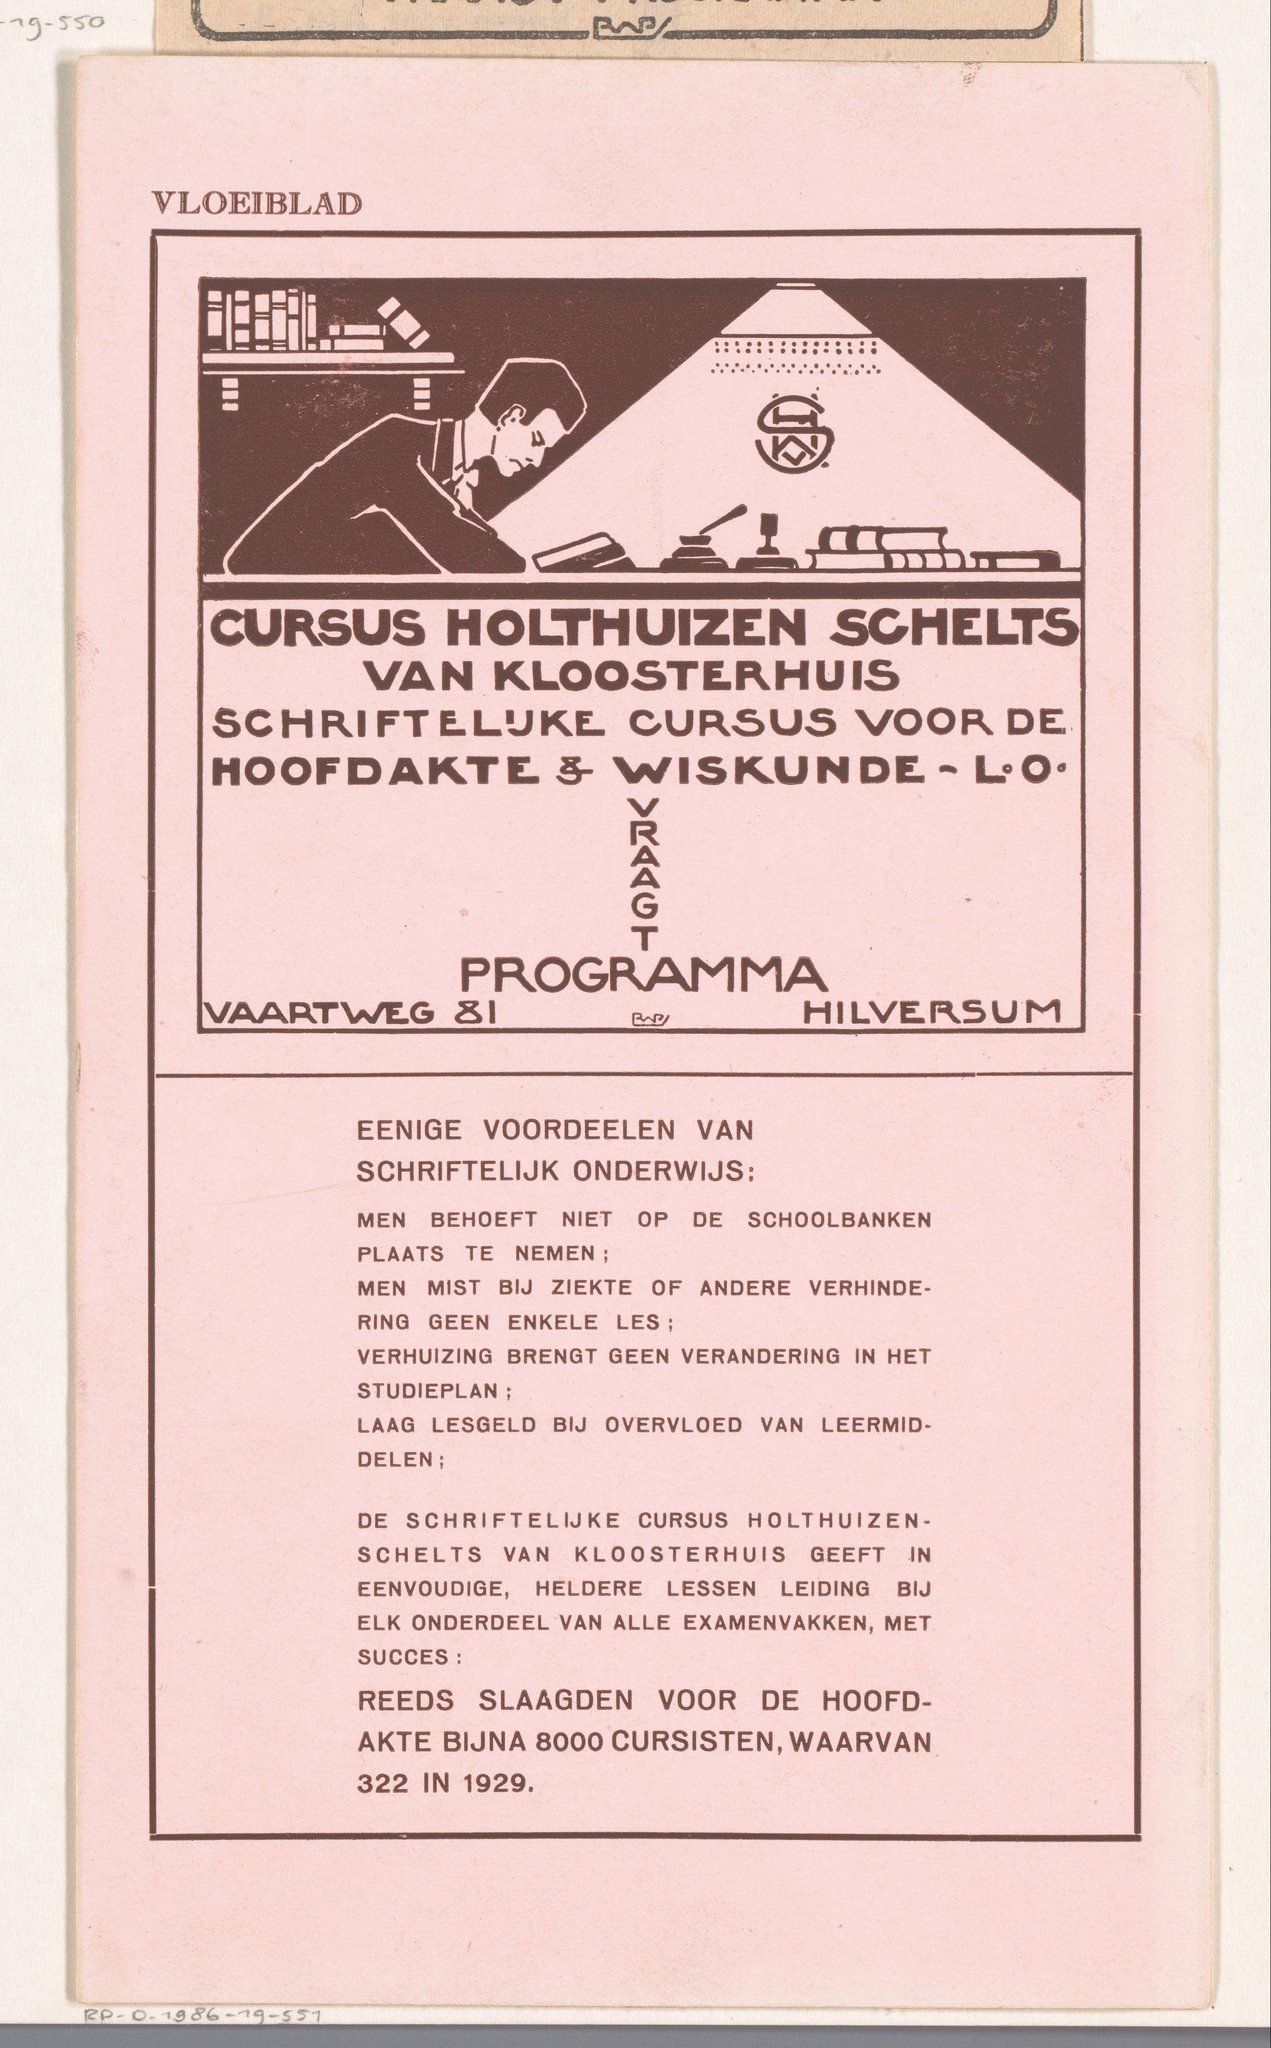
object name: photomechanical print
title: Advertentie voor Cursus Holthuizen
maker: reinier willem petrus de vries (1874-1953)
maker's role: draughtsman, print maker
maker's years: 1874-1953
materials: paper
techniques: printing block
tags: reading, writing accessories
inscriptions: collector's mark: ‘R:MVS.’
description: Advertentie met een studerende man aan een tafel. Op de tafel liggen boeken en schrijfgerei.